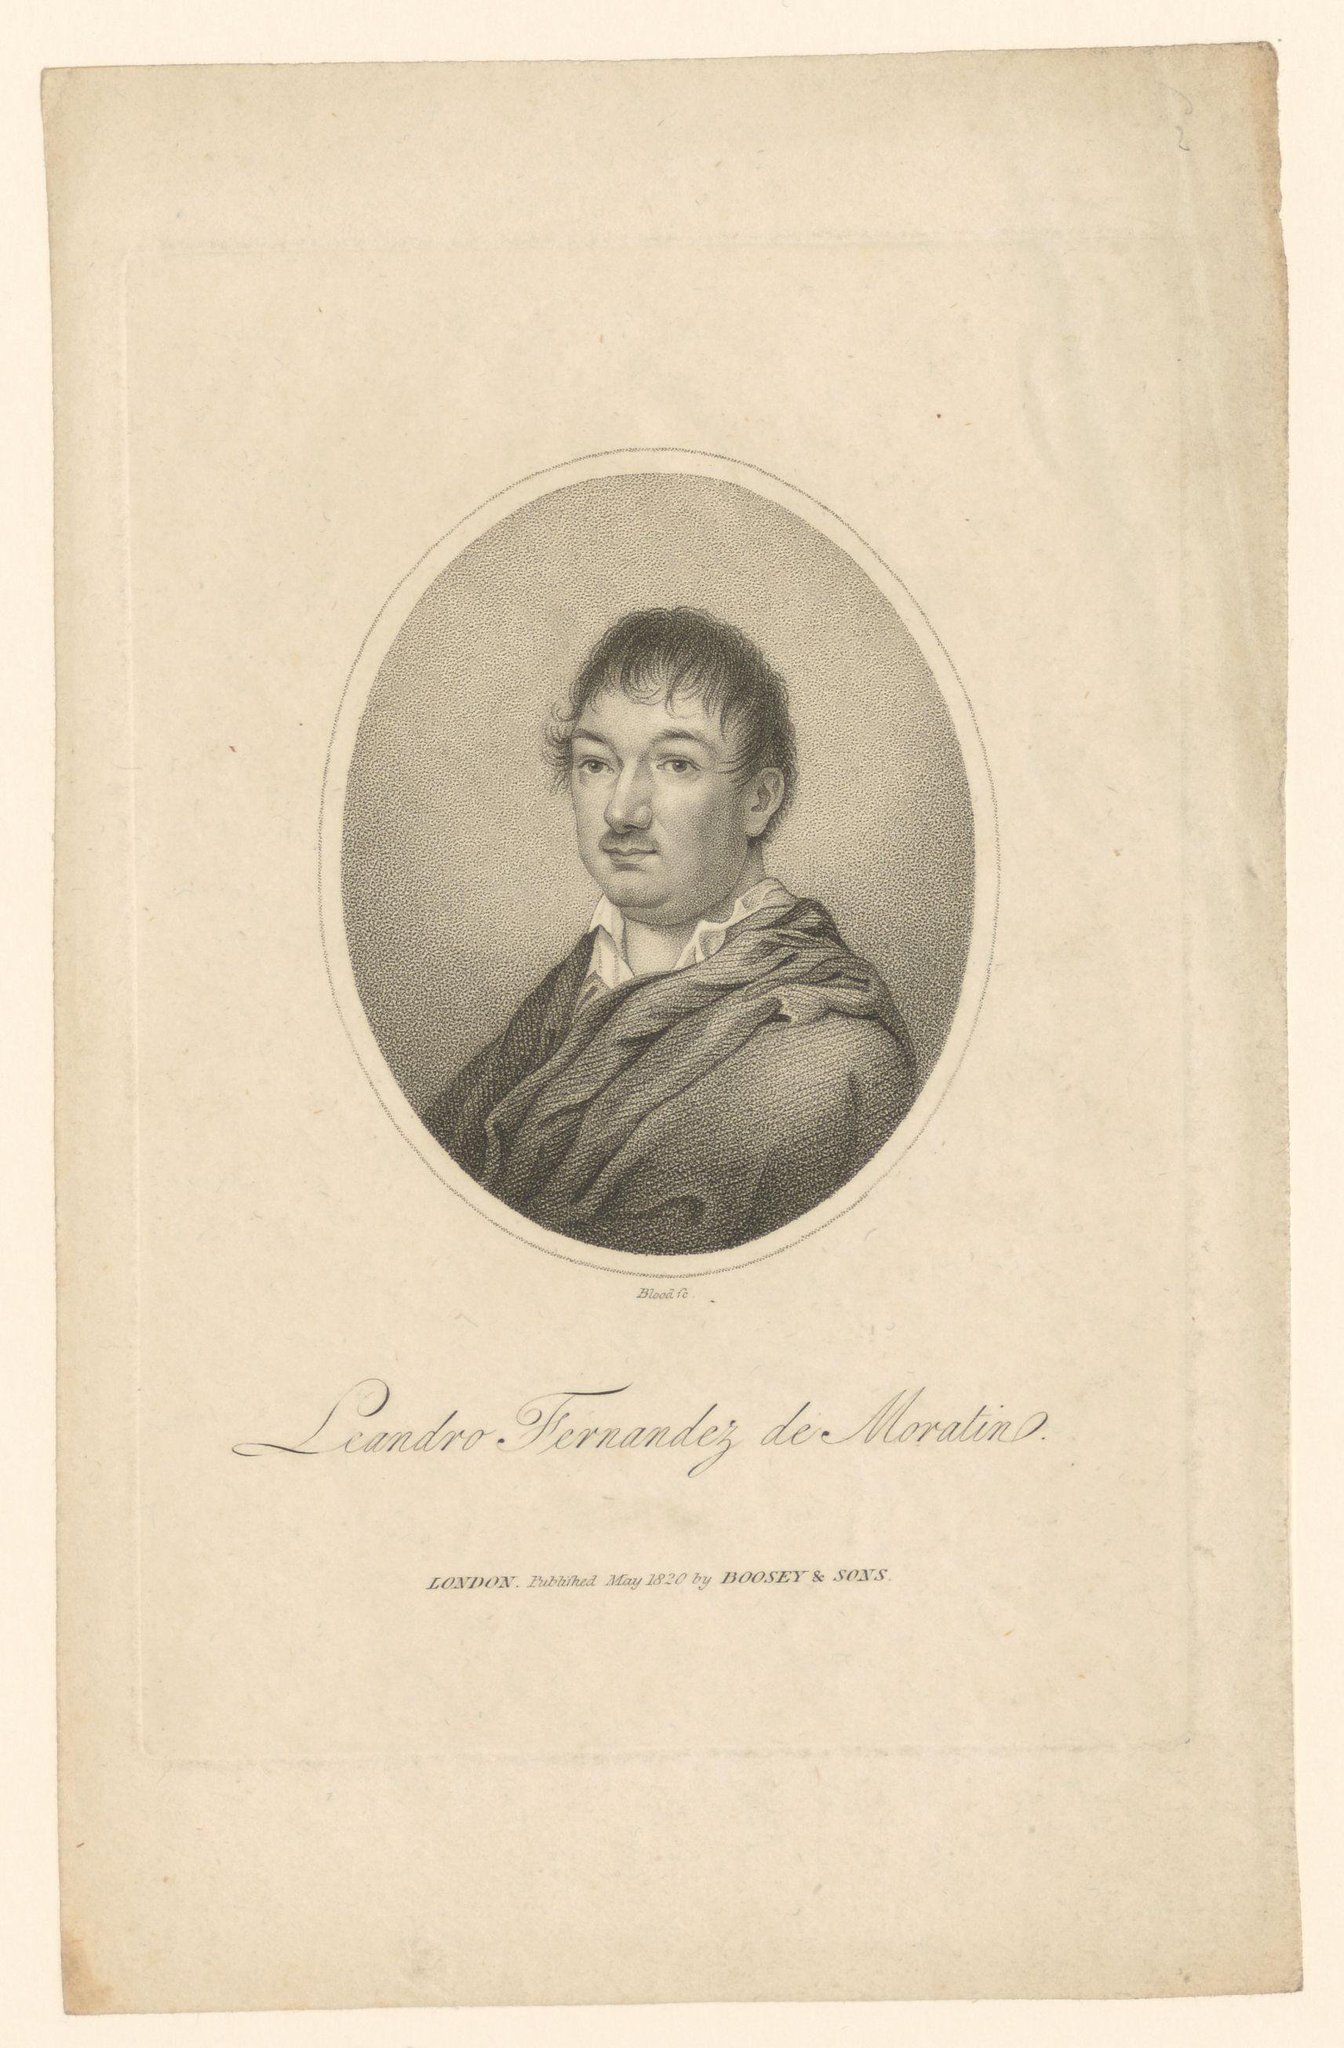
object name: print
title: Portret van Leandro Fernández de Moratín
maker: thomas blood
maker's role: print maker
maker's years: 1777-1850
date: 1805-1820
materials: paper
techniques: etching, engraving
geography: london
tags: historical persons, portrait of a writer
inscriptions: collector's mark: Lugt 2228